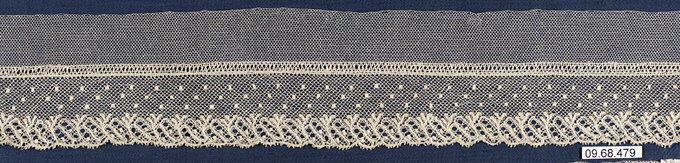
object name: fragment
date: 1801-1900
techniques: lace